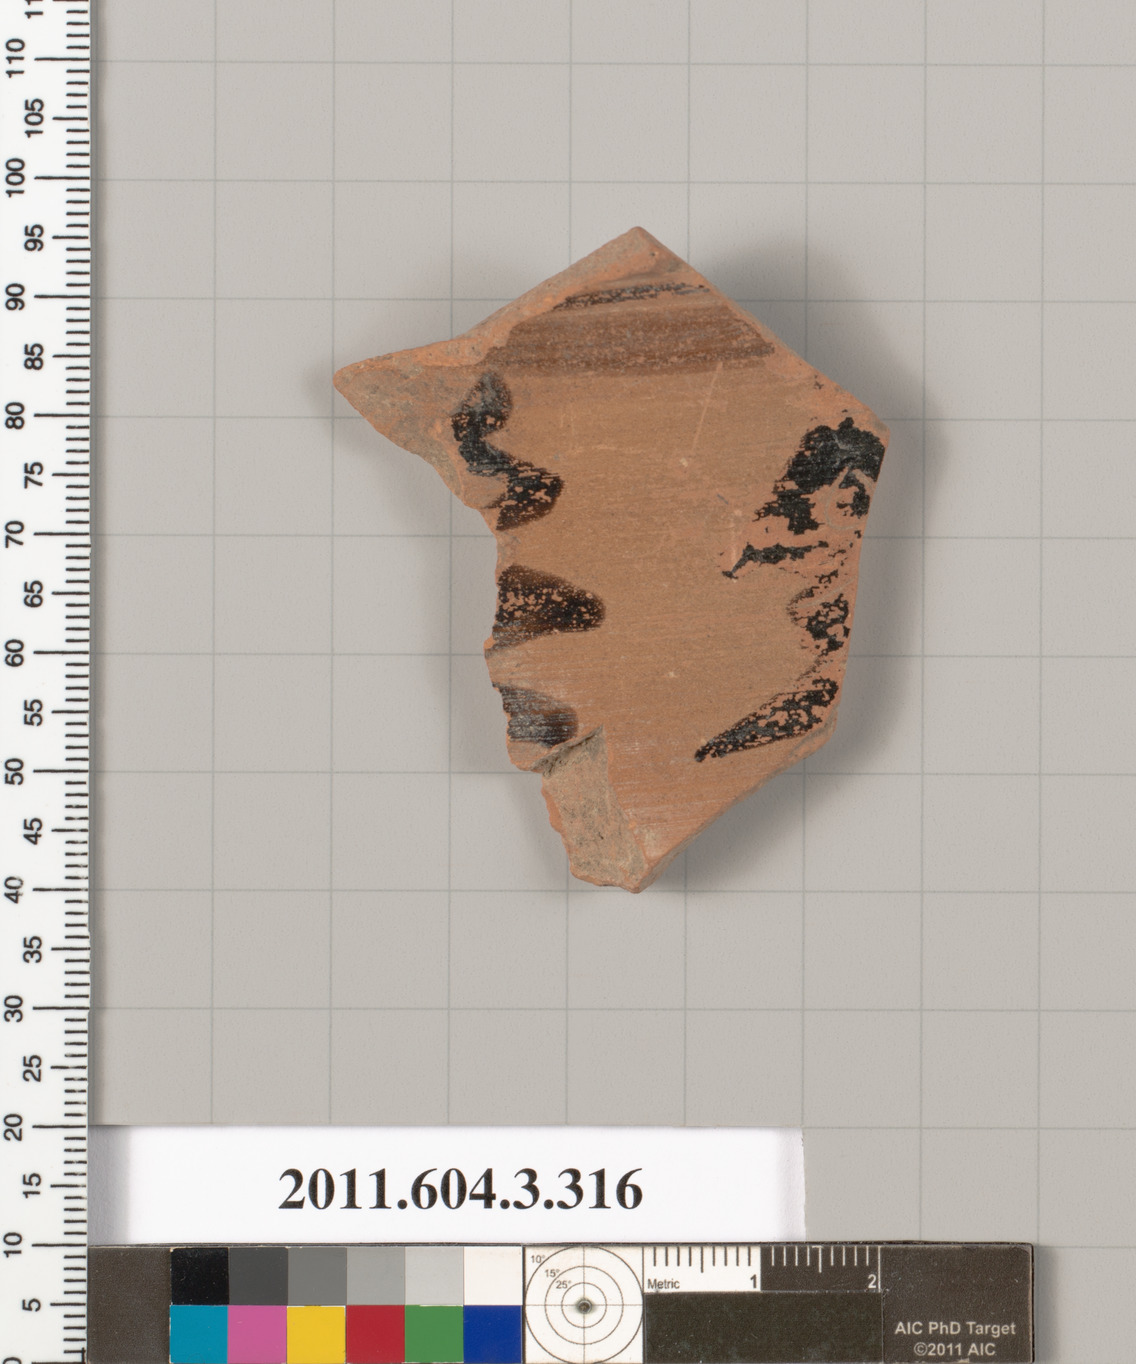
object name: neck amphora fragment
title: Terracotta fragment of an neck-amphora (jar)?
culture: greek, attic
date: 600-501 BCE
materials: terracotta